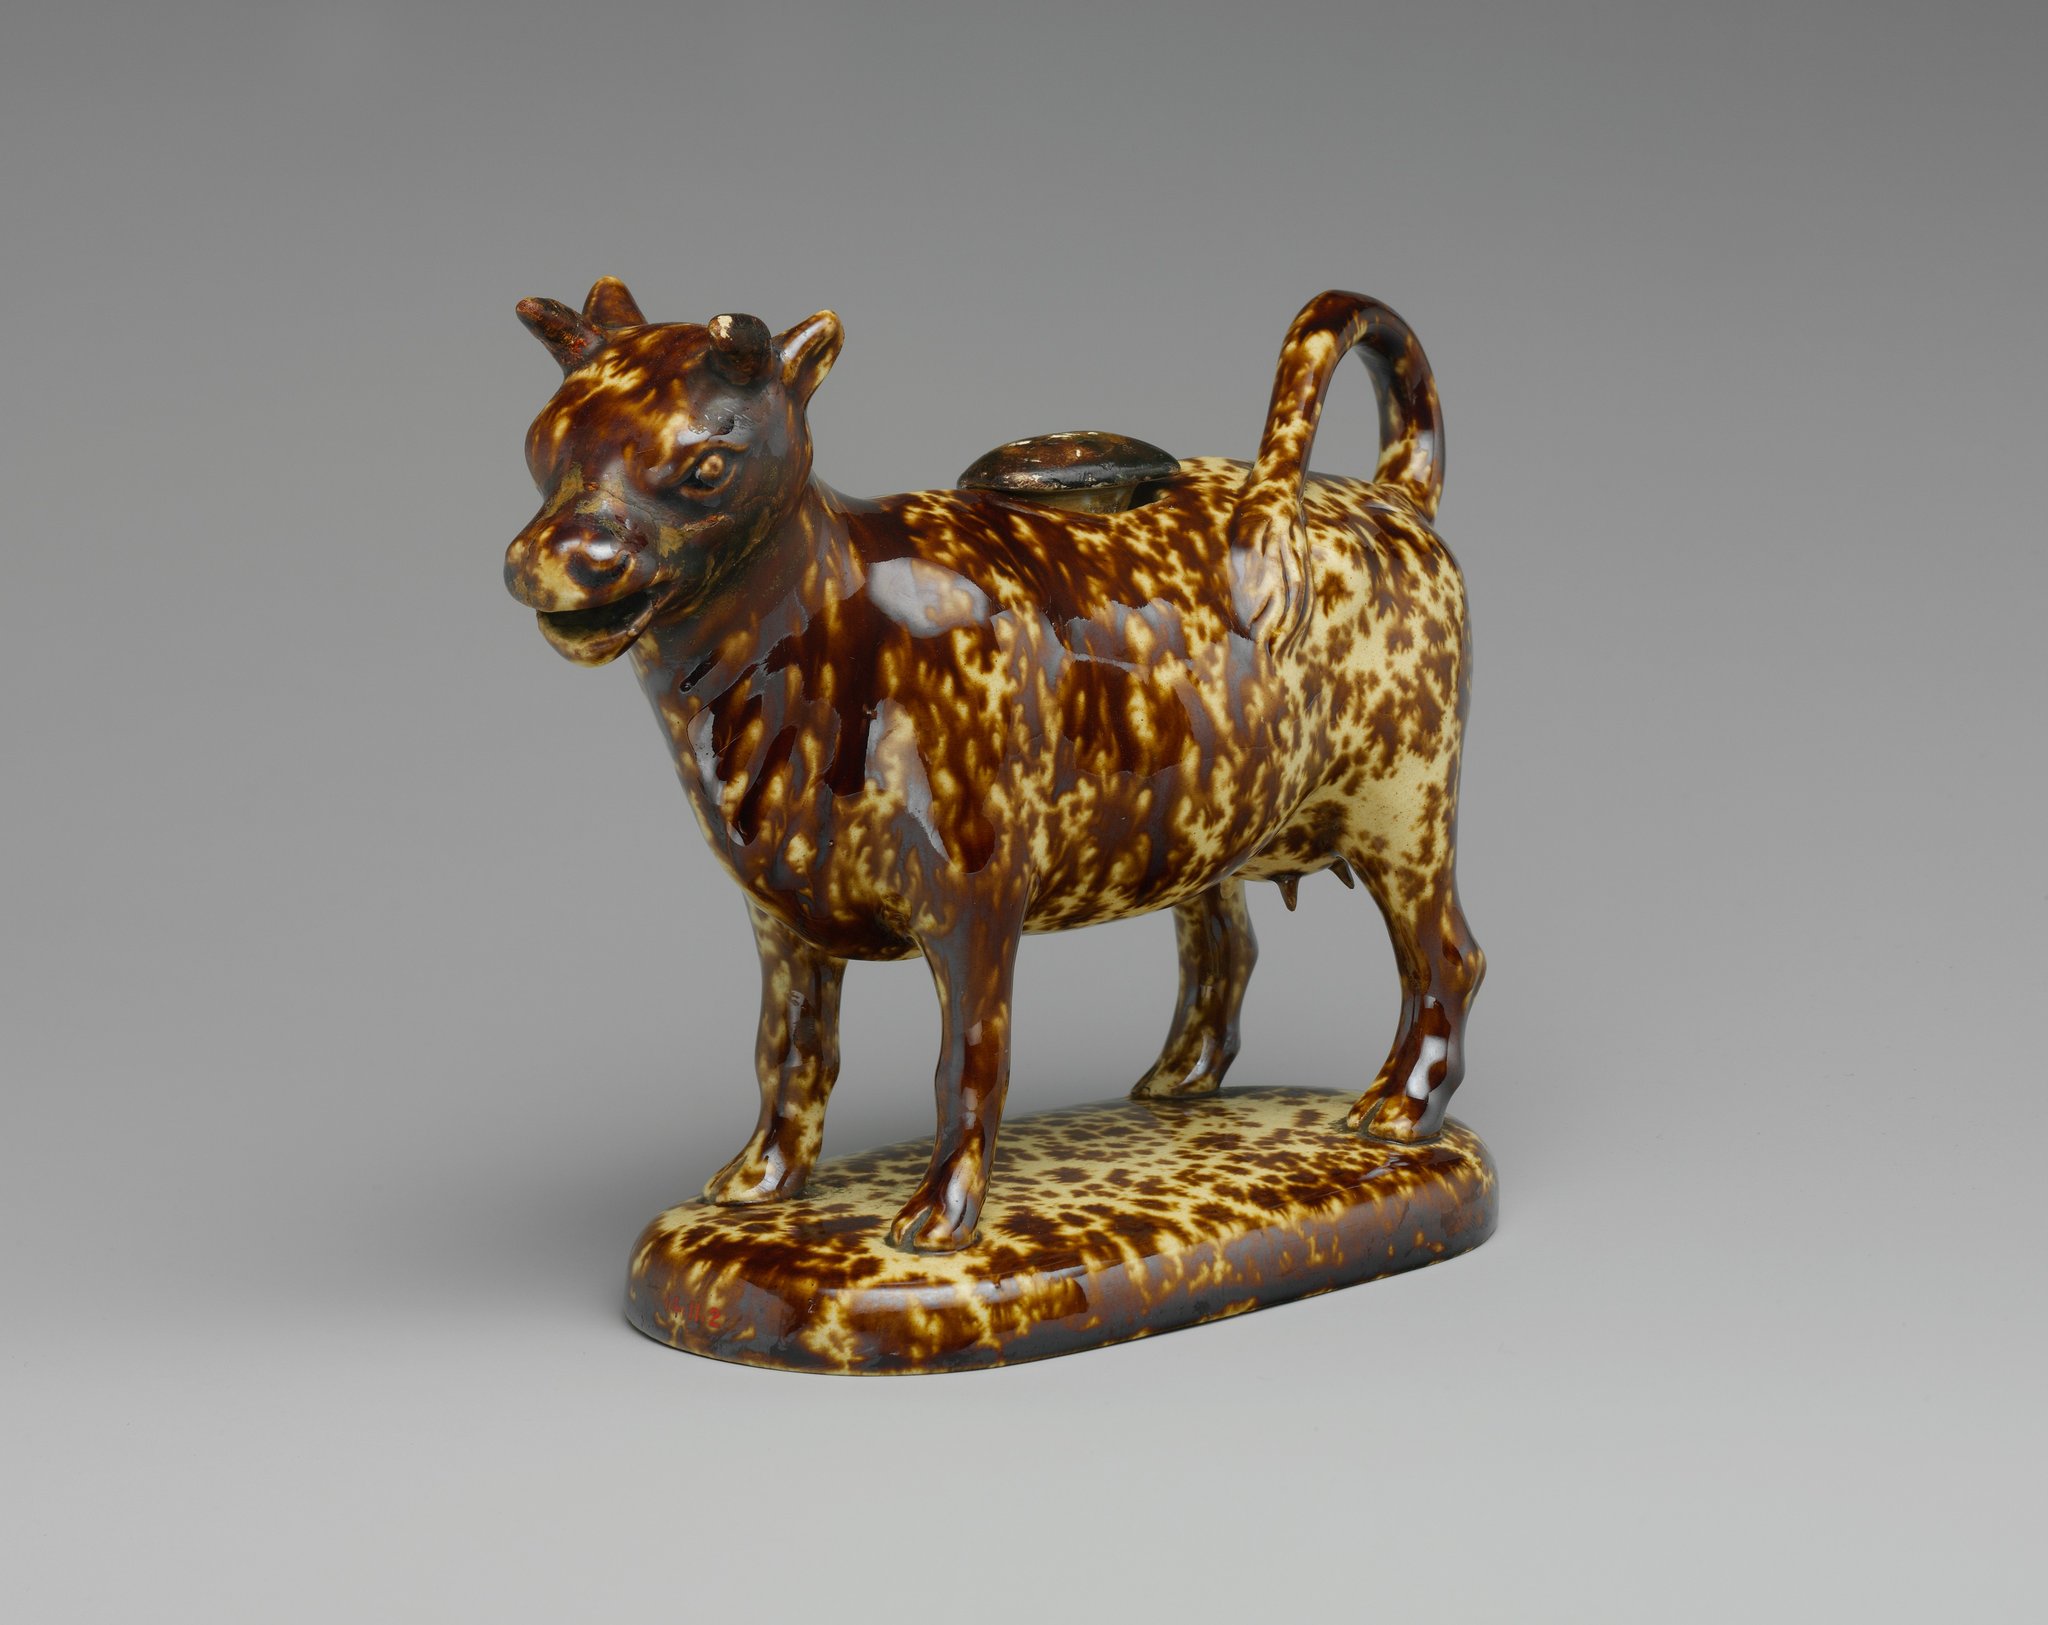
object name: cream jug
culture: american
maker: daniel greatbatch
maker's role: designer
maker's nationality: british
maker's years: 1838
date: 1852-1858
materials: earthenware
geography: united states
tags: cows